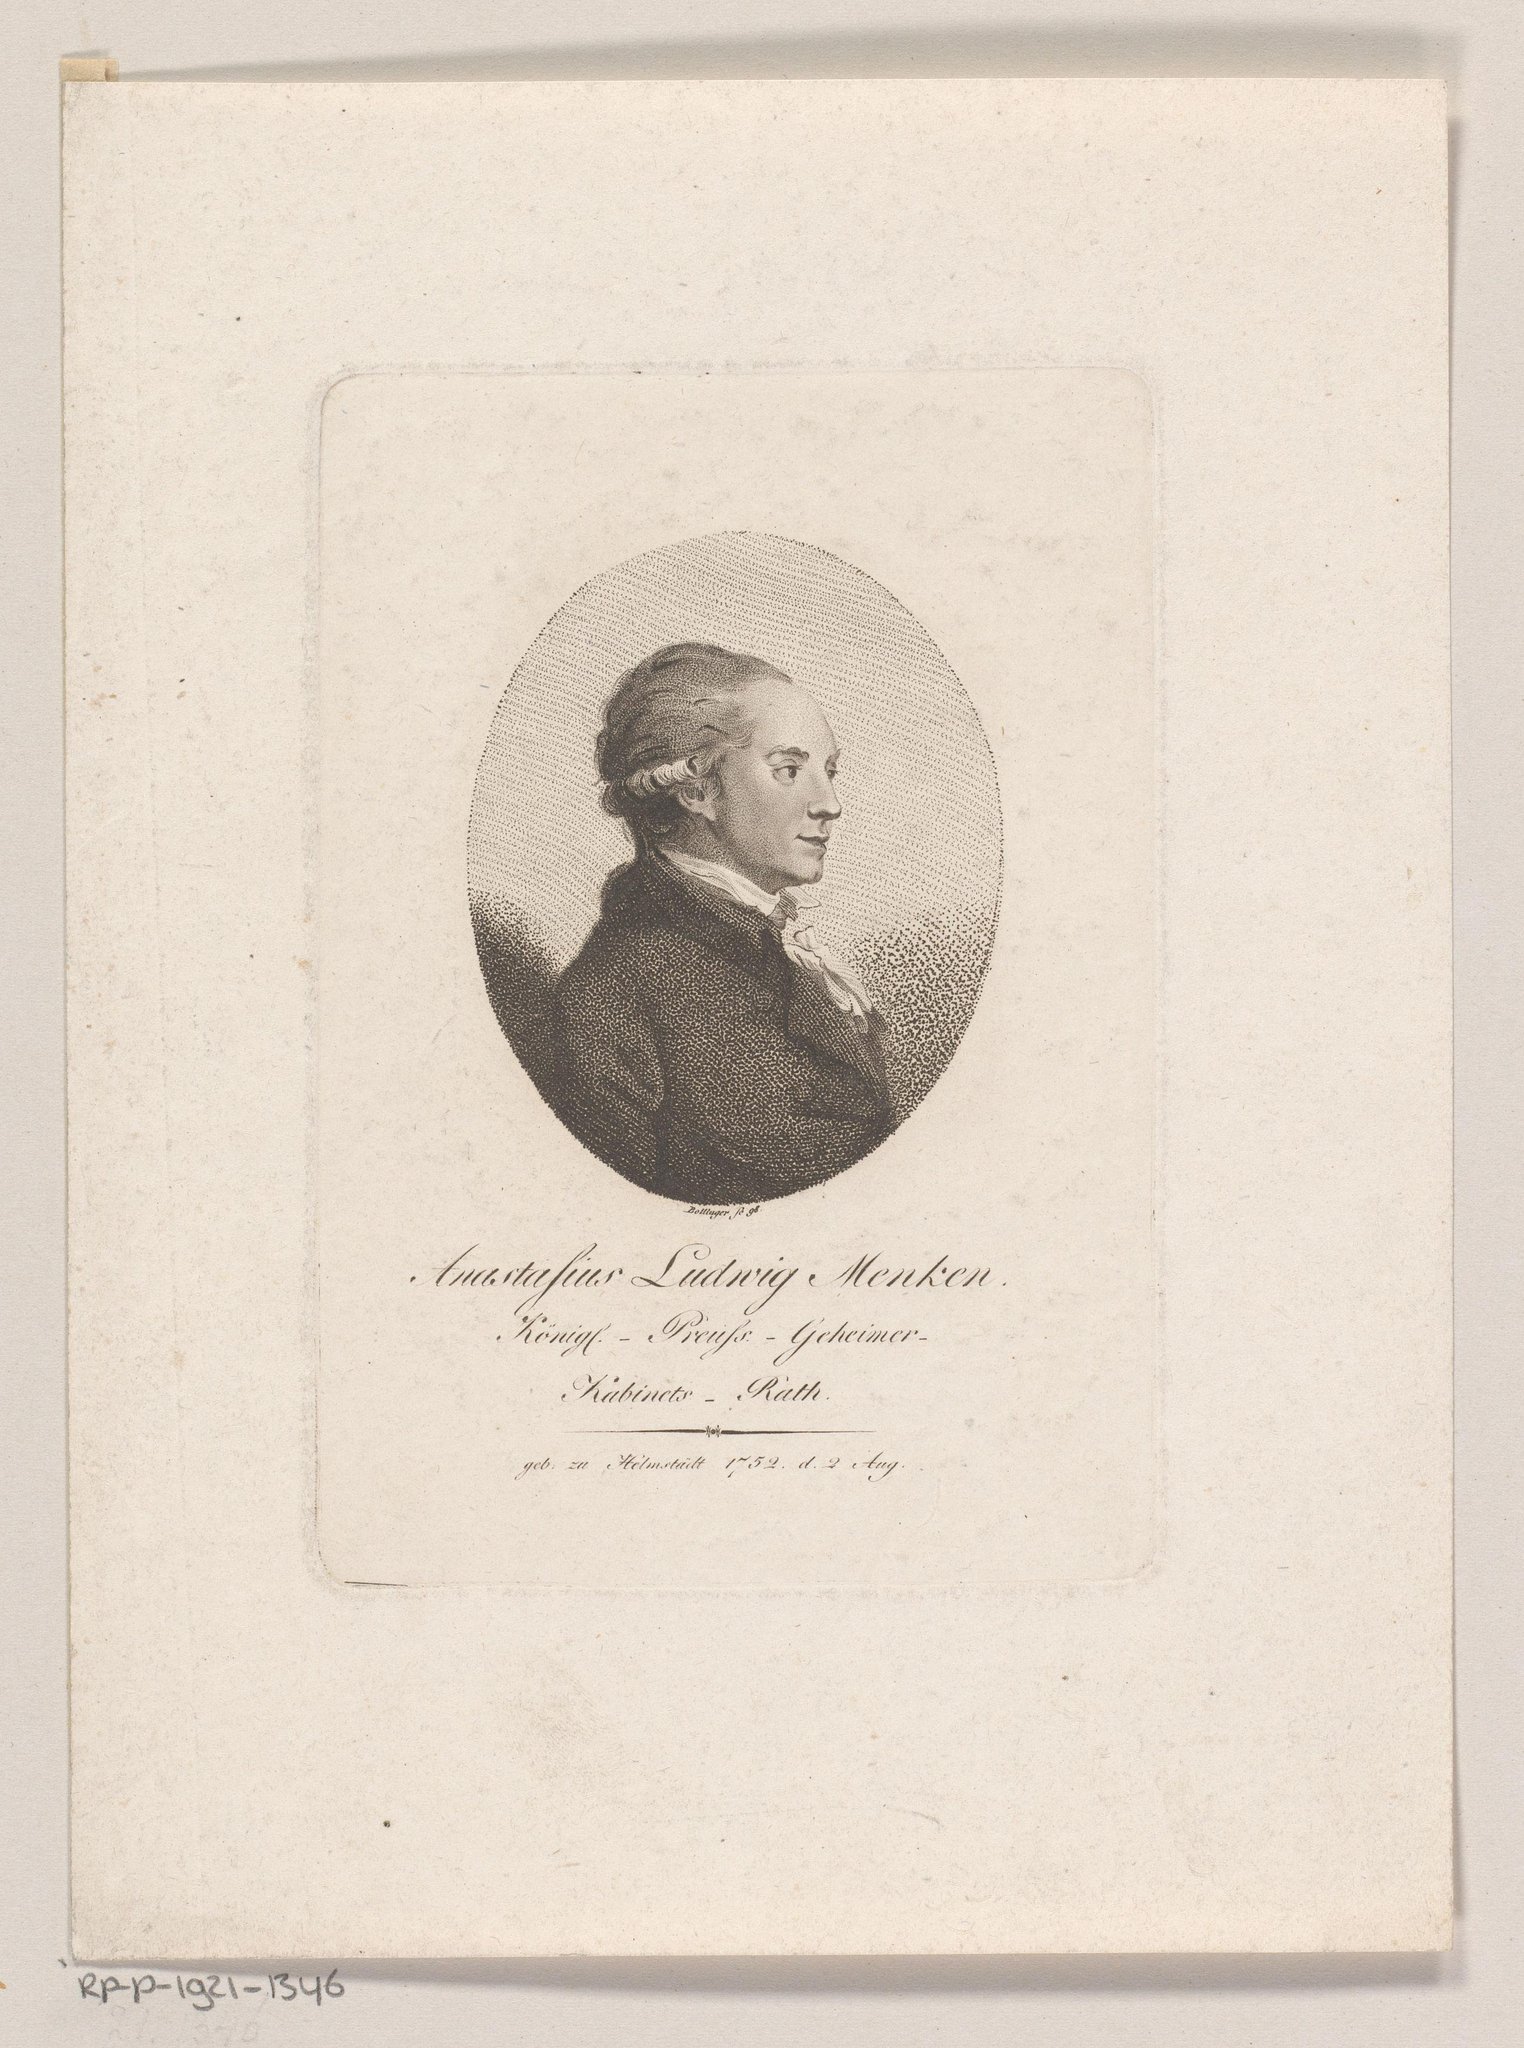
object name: print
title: Portret van Anastasius Ludwig Mencke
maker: friedrich wilhelm bollinger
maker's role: print maker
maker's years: 1777-1825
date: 1798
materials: paper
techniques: roulette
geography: berlin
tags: historical persons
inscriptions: collector's mark: Lugt 2233